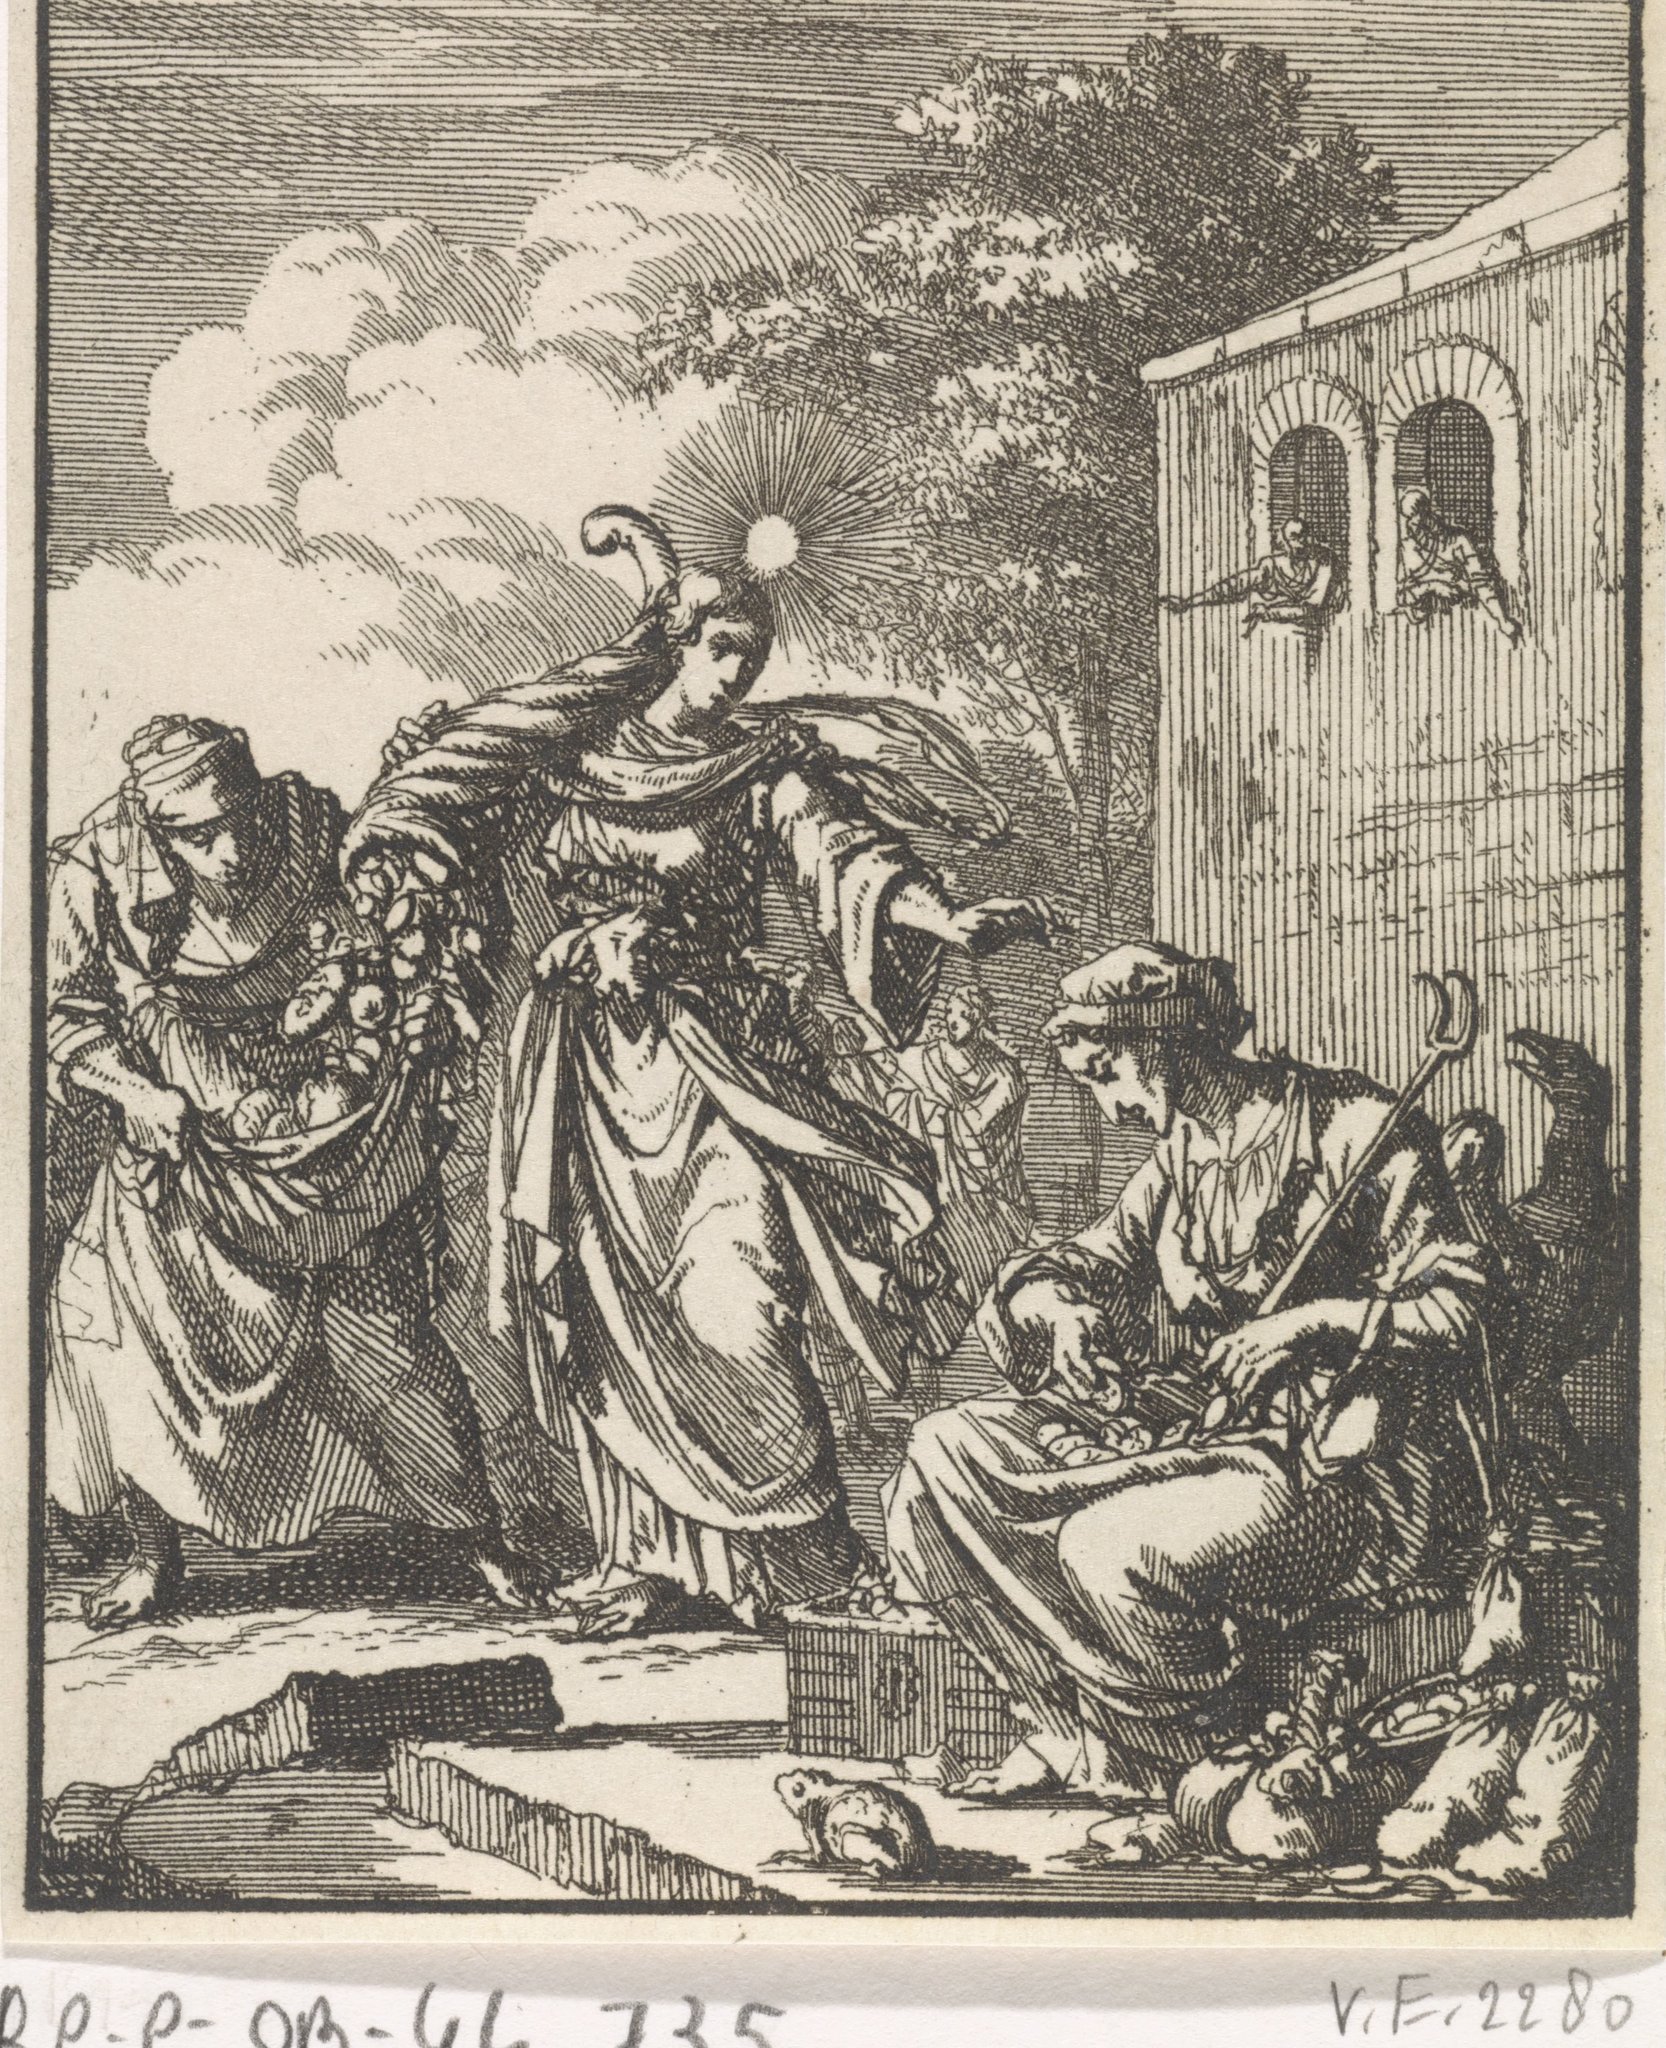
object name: book illustration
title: Gierigheid en Weldadigheid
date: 1699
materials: paper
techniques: etching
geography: amsterdam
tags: 'cornucopia', horn of plenty, covetousness; 'avaritia' (ripa) ~ personification of one of the seven deadly sins, wealth, opulence; 'opulenza', 'richezza' (ripa)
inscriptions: collector's mark: Lugt 2228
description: Op de voorgrond de vrouwelijke personificatie Gierigheid. Ze verzamelt haar rijkdommen rondom haar. Links de vrouwelijke personificatie Weldadigheid. Ze deelt met een Hoorn des Overvloeds rijkdommen uit.